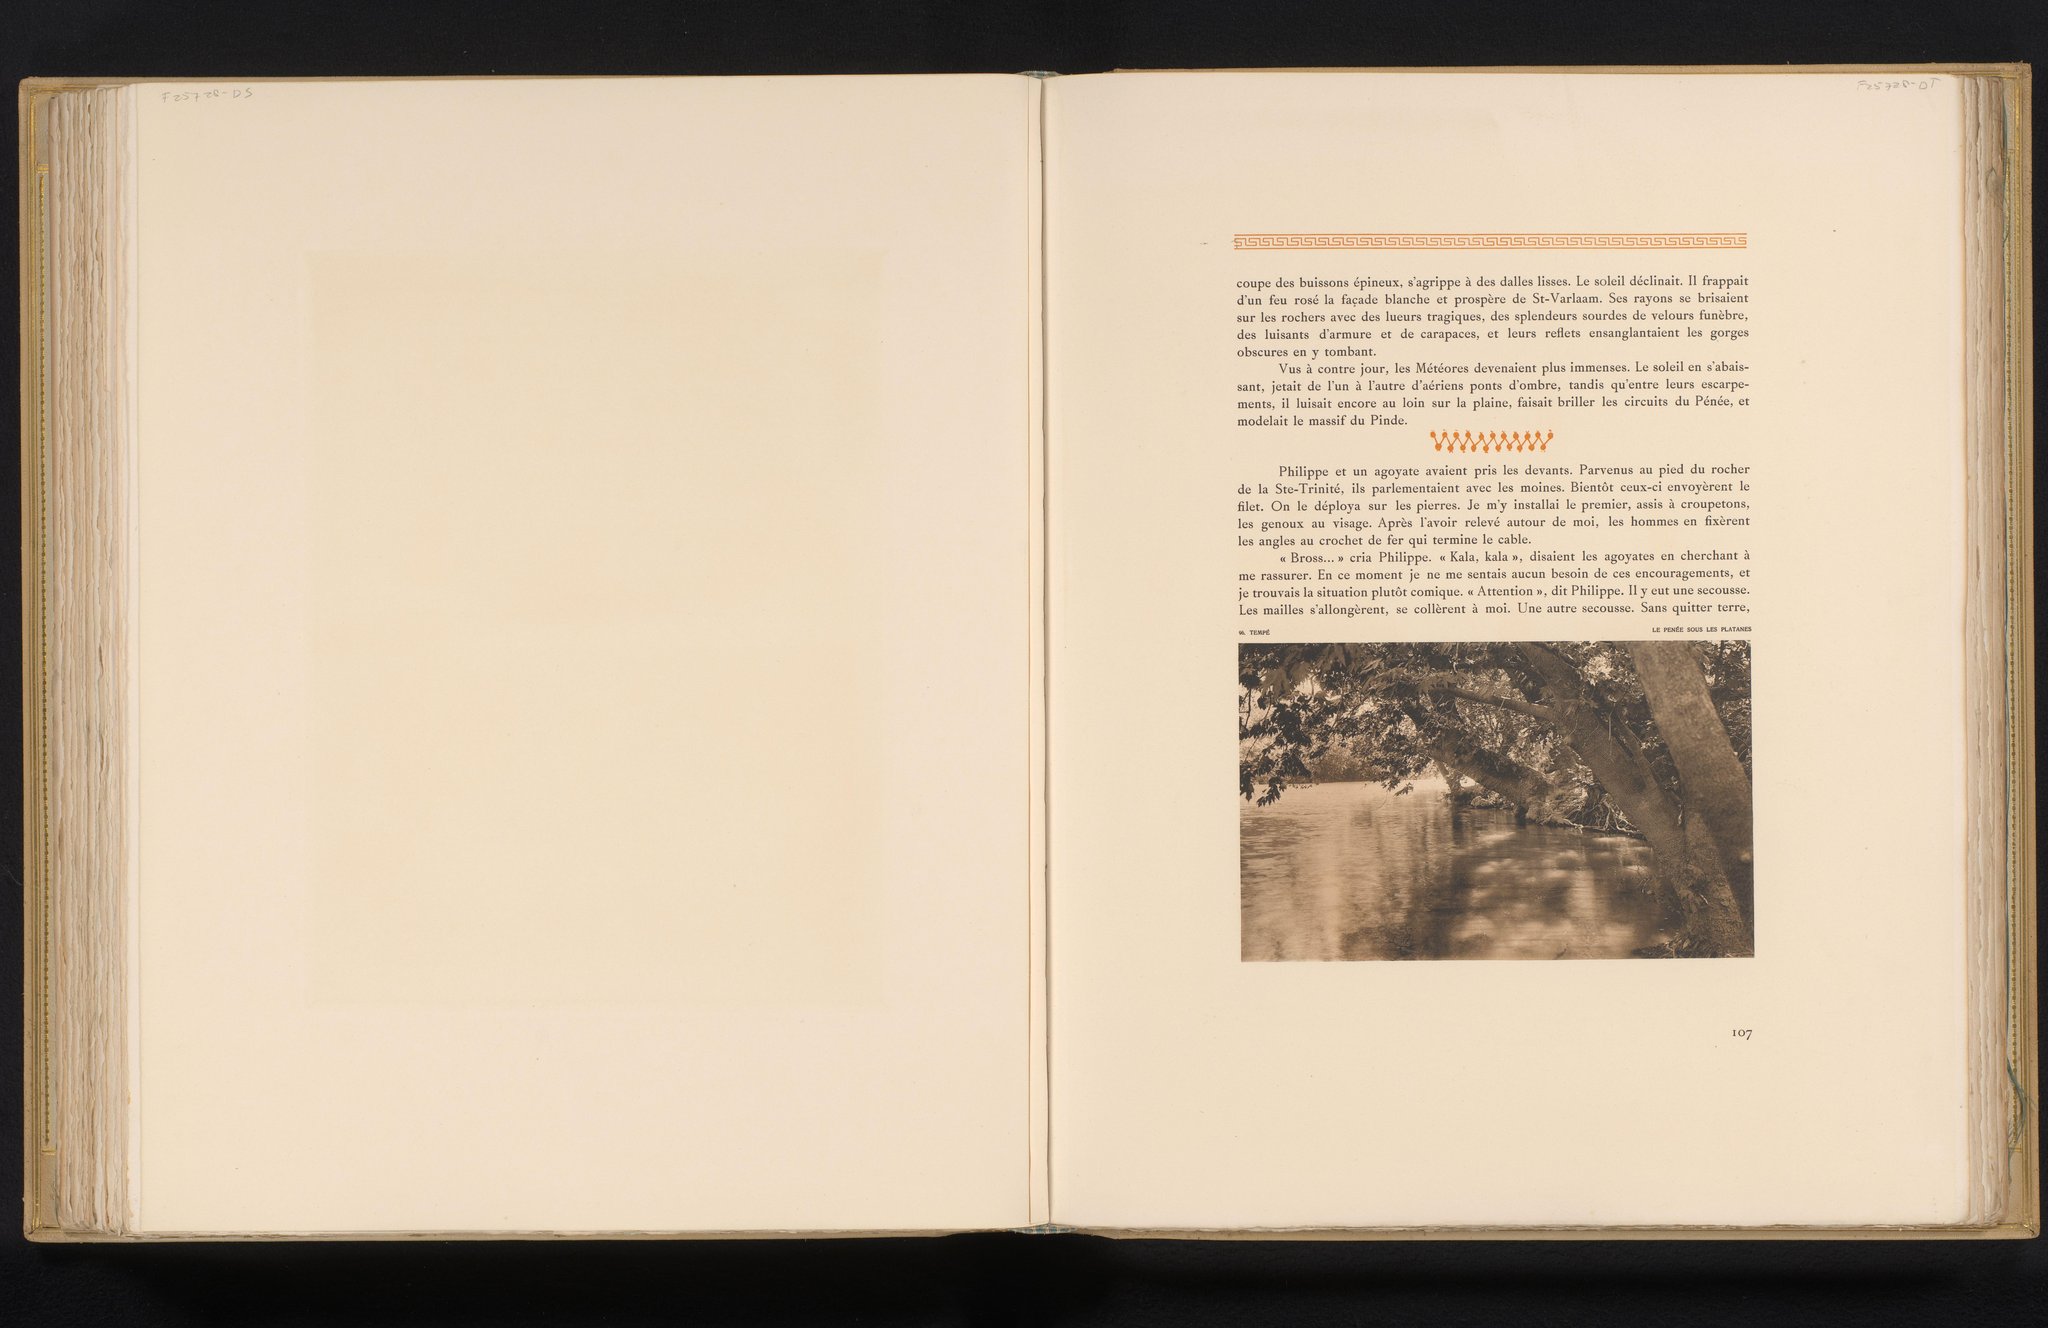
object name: page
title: Tempé, le Penée sous les platanes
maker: frédéric boissonnas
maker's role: fotograaf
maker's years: 1858-1946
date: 1905-1910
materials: paper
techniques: photograph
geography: tempedal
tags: river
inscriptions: number: ‘96.’